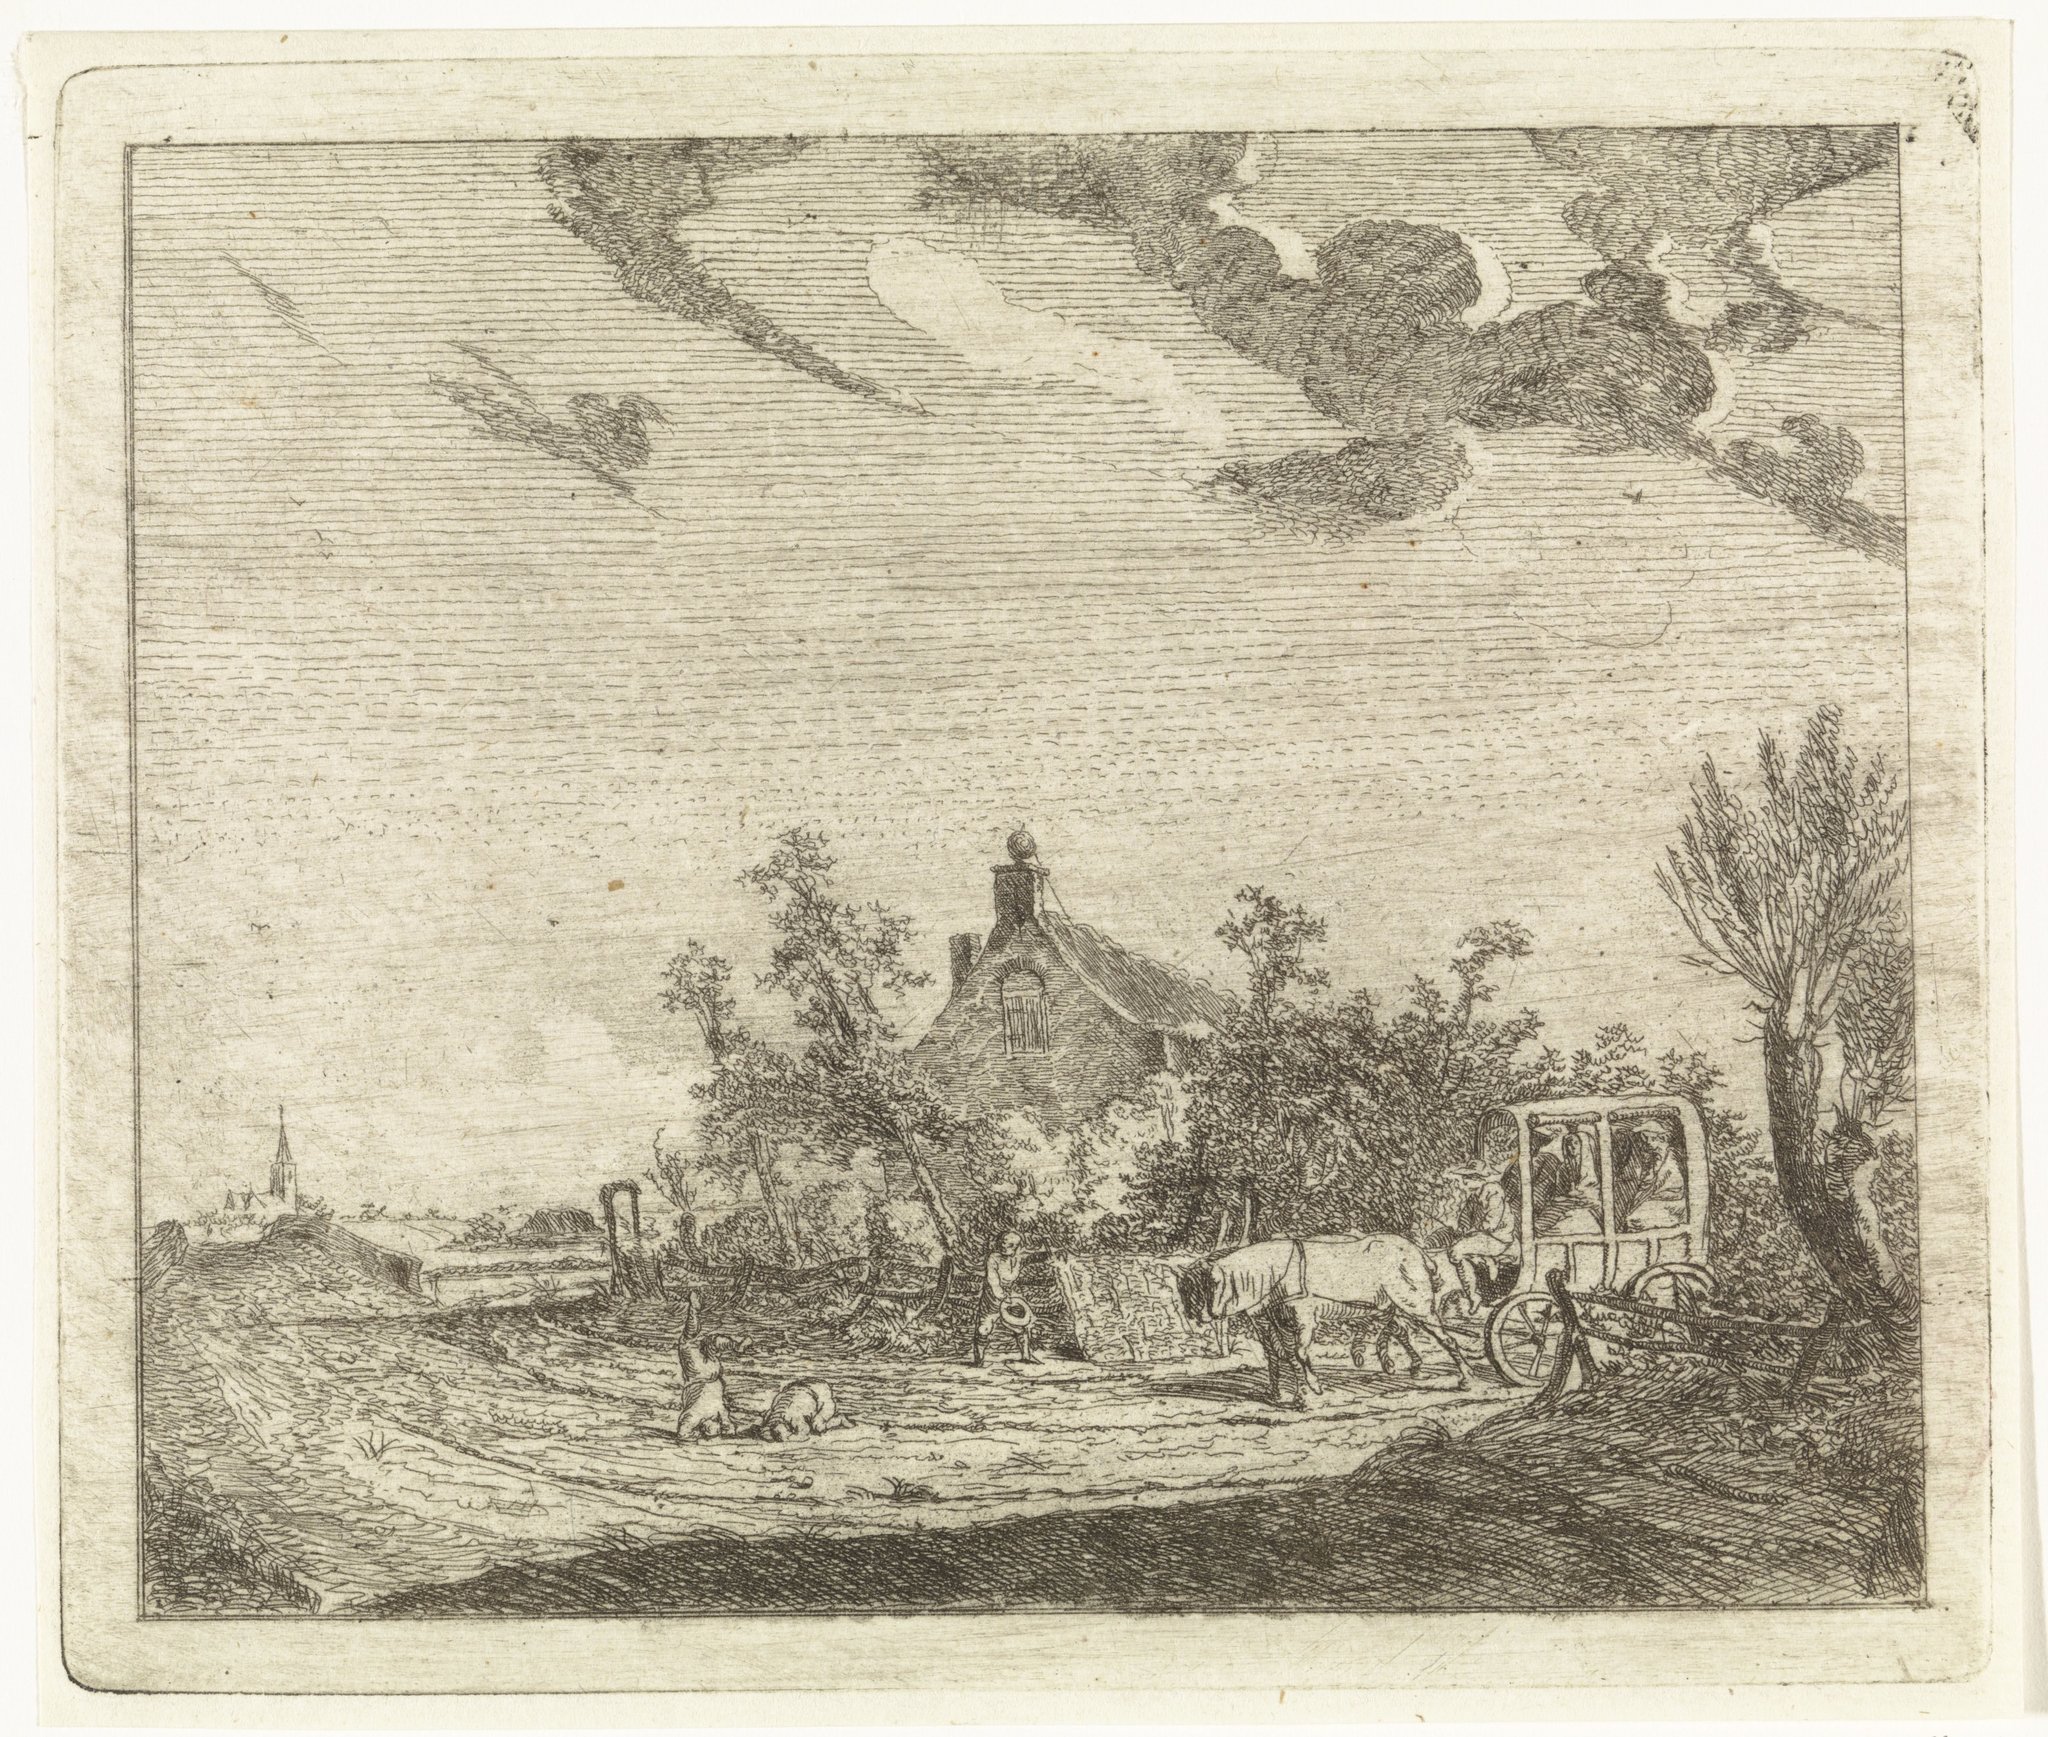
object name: print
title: Paard en wagen voor een huis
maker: johannes huibert prins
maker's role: draughtsman, painter, print maker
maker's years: 1757-1806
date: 1767-1806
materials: paper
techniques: etching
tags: stand on the head ~ jumping games, rural housing, e.g. country-house, villa, cottage, covered wagon, hooded wagon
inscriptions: collector's mark: Lugt 240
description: Voor een huis rijdt een koets over een weg met daarin enkele reizigers die dekens omgeslagen hebben. Op de weg spelen twee kinderen 'handstand'.